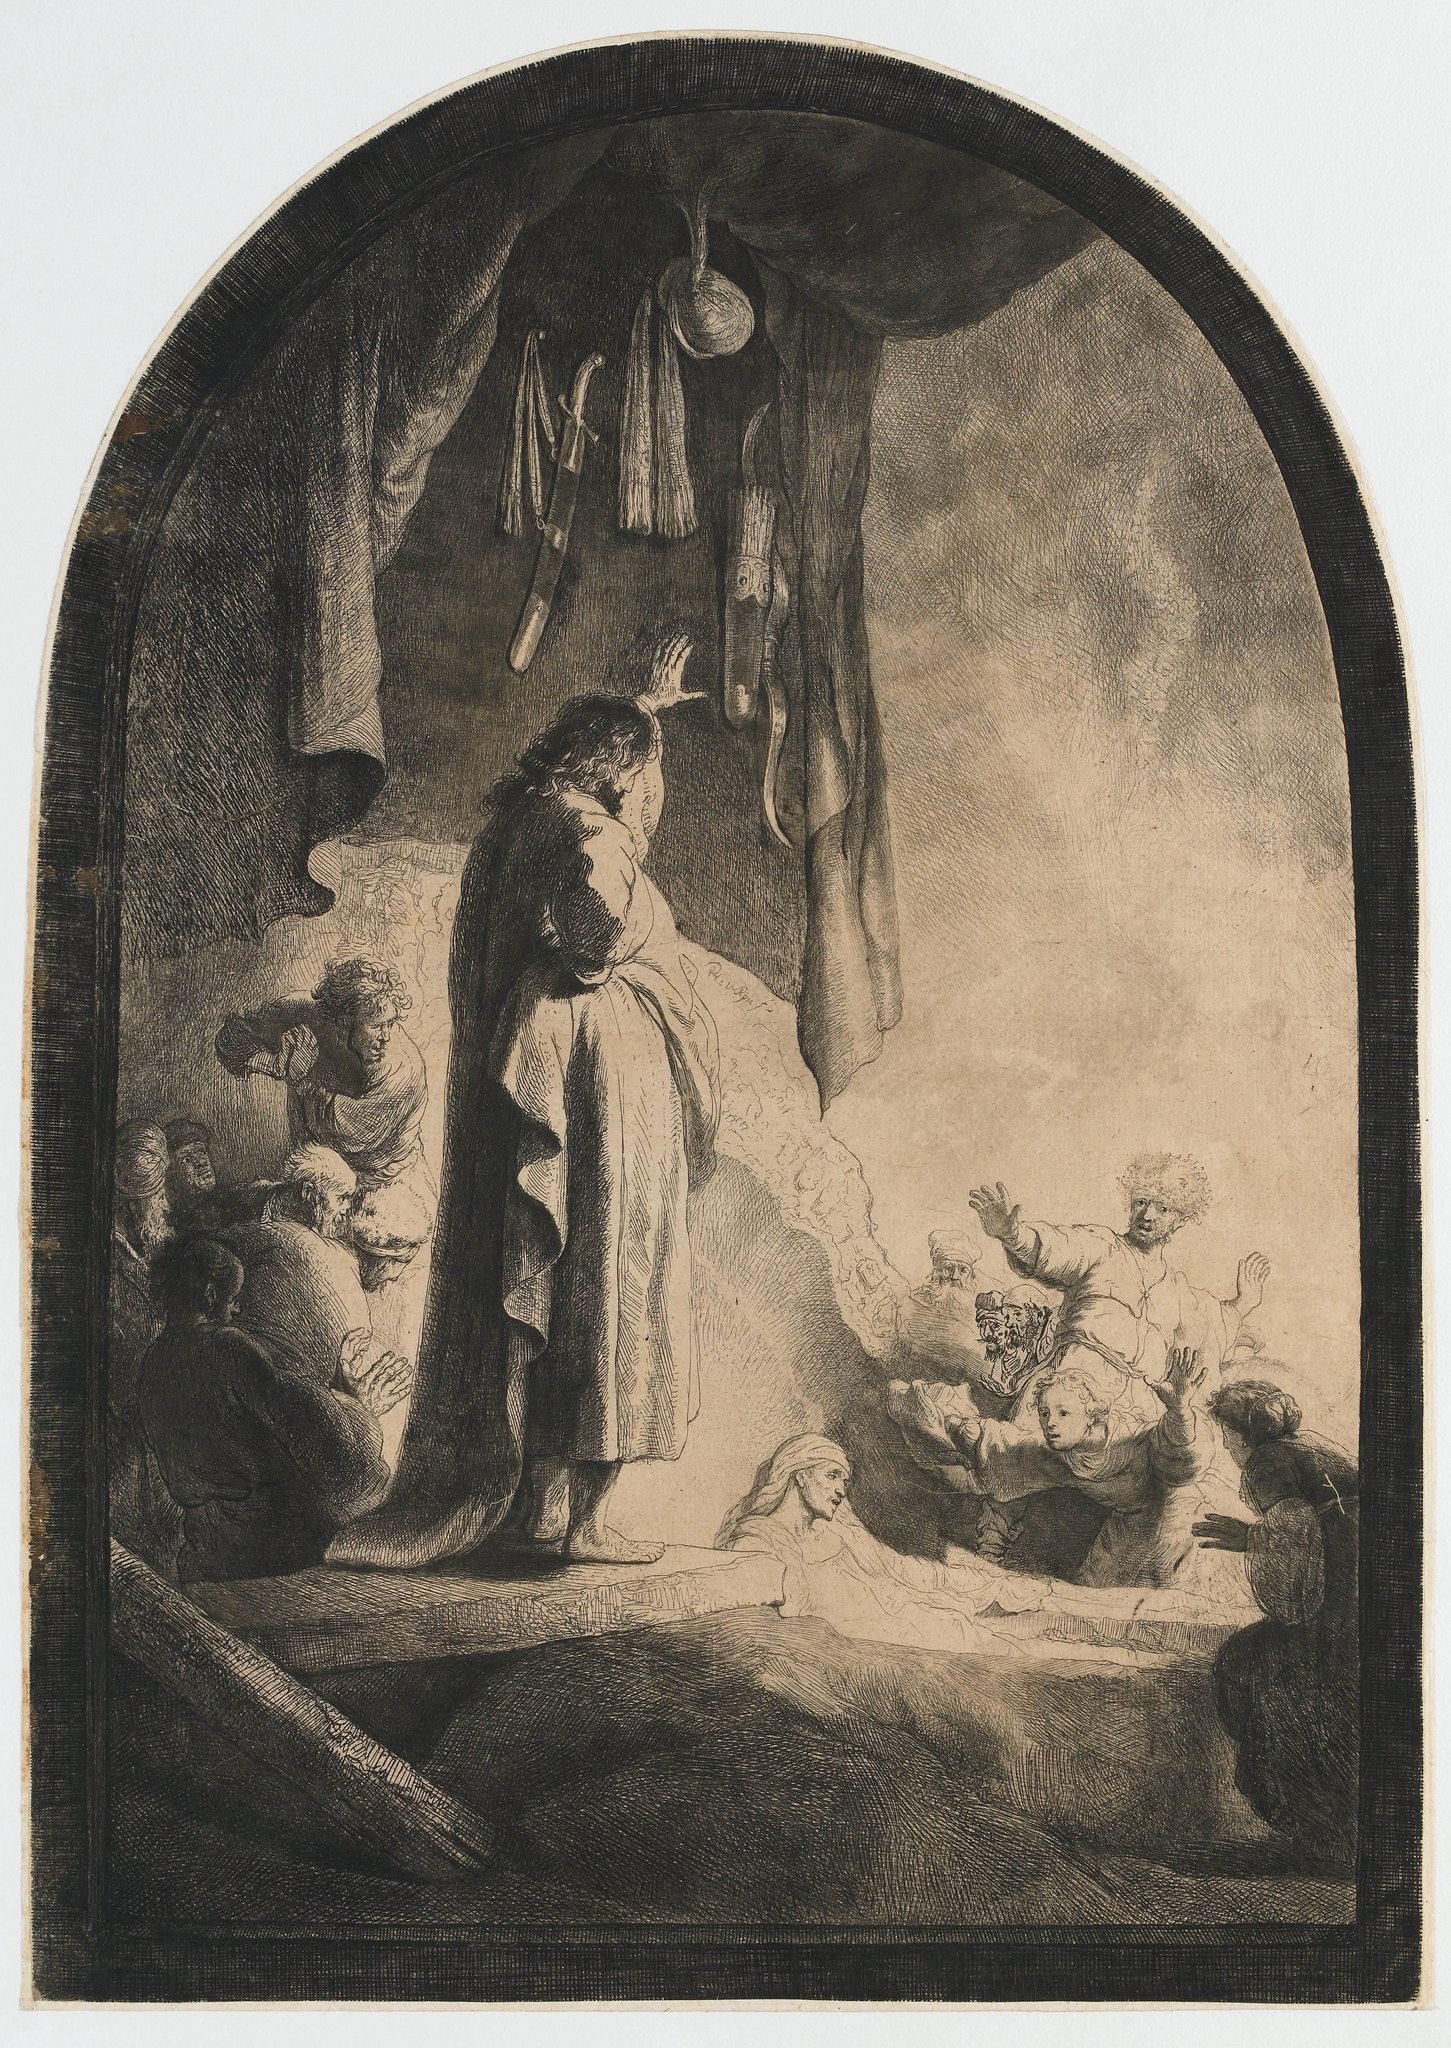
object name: print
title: The raising of Lazarus: the larger plate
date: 1632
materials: ink, paper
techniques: etching, pen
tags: the raising of lazarus ('lazarus, come out')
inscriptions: signature: ‘RHL. v Rijn f.’, collector's mark: Lugt 240